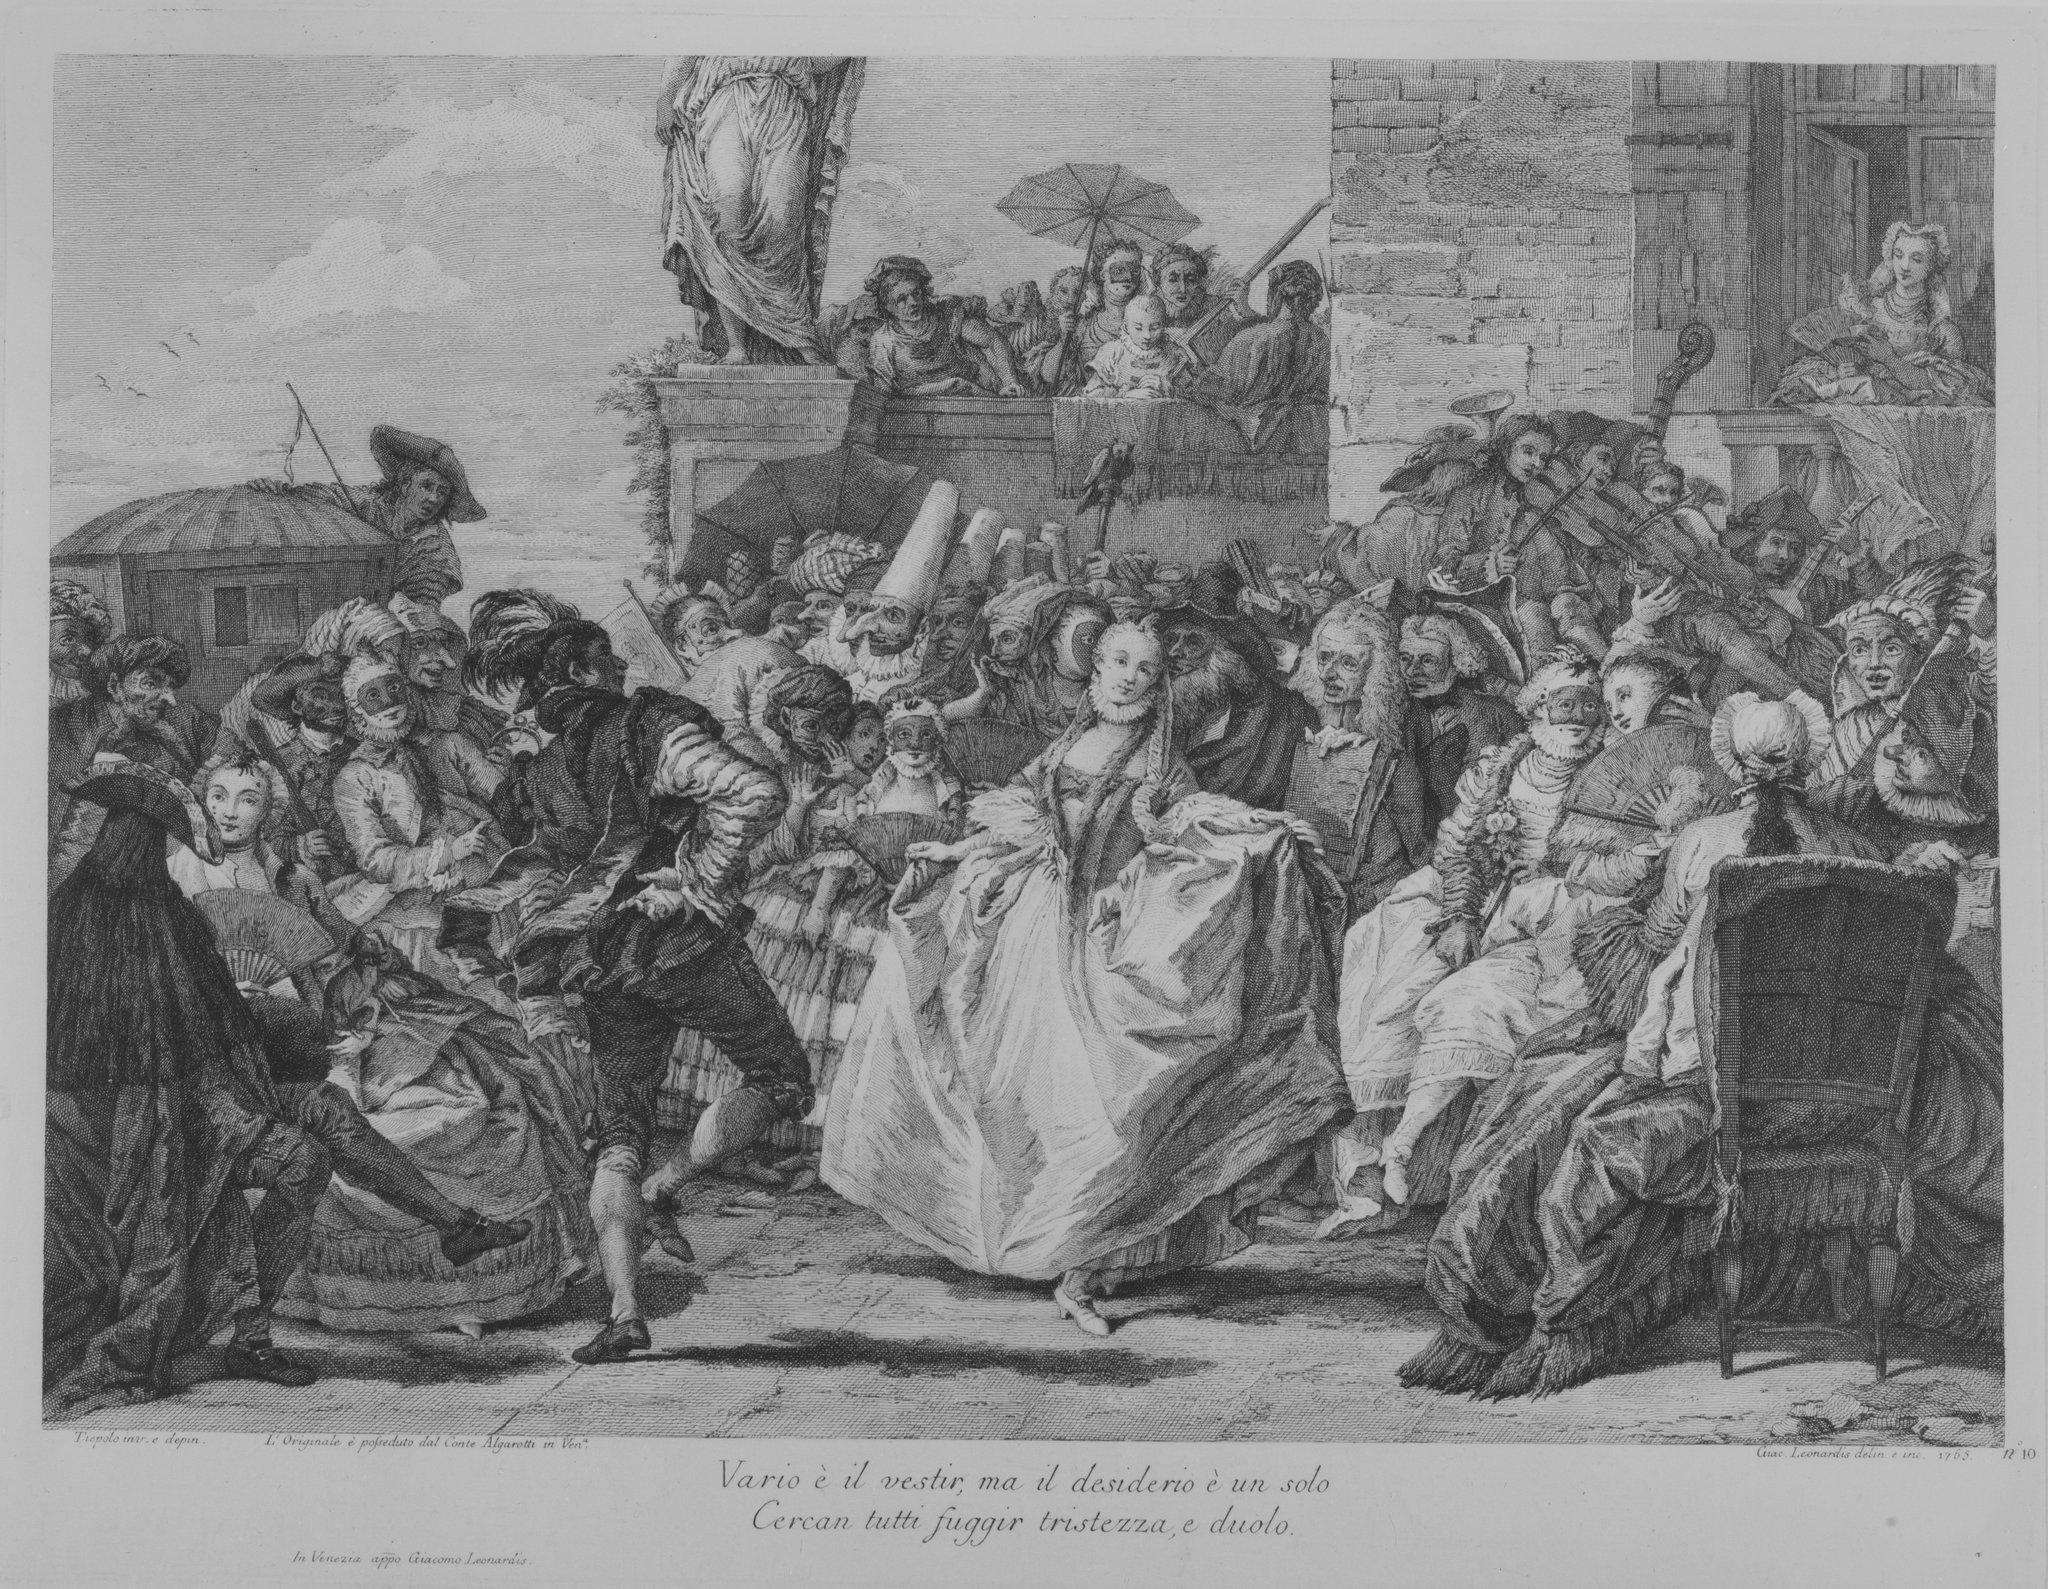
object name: print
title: The Minuet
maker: giacomo leonardis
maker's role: artist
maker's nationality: italian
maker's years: 1723-1794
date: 1765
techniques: engraving, etching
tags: musical instruments,men,women,dancing